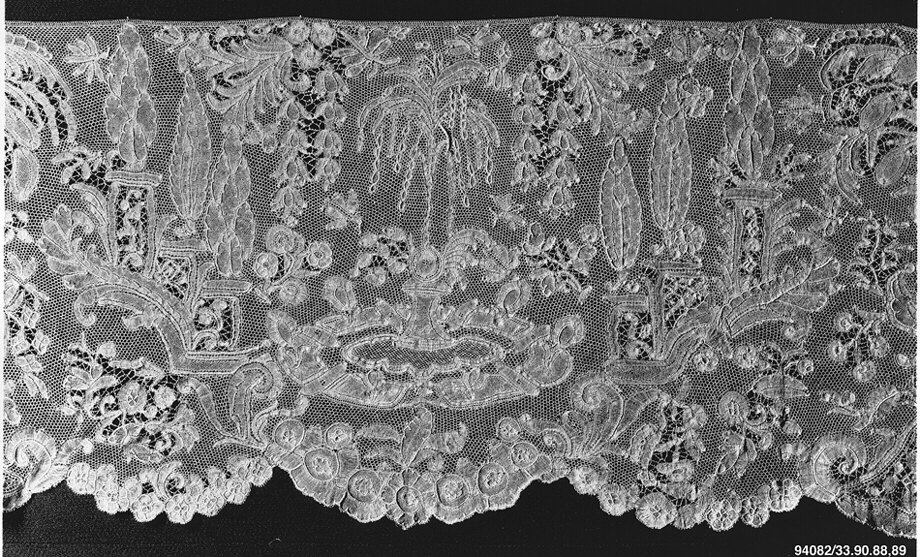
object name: flounce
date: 1701-1733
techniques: lace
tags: flowers